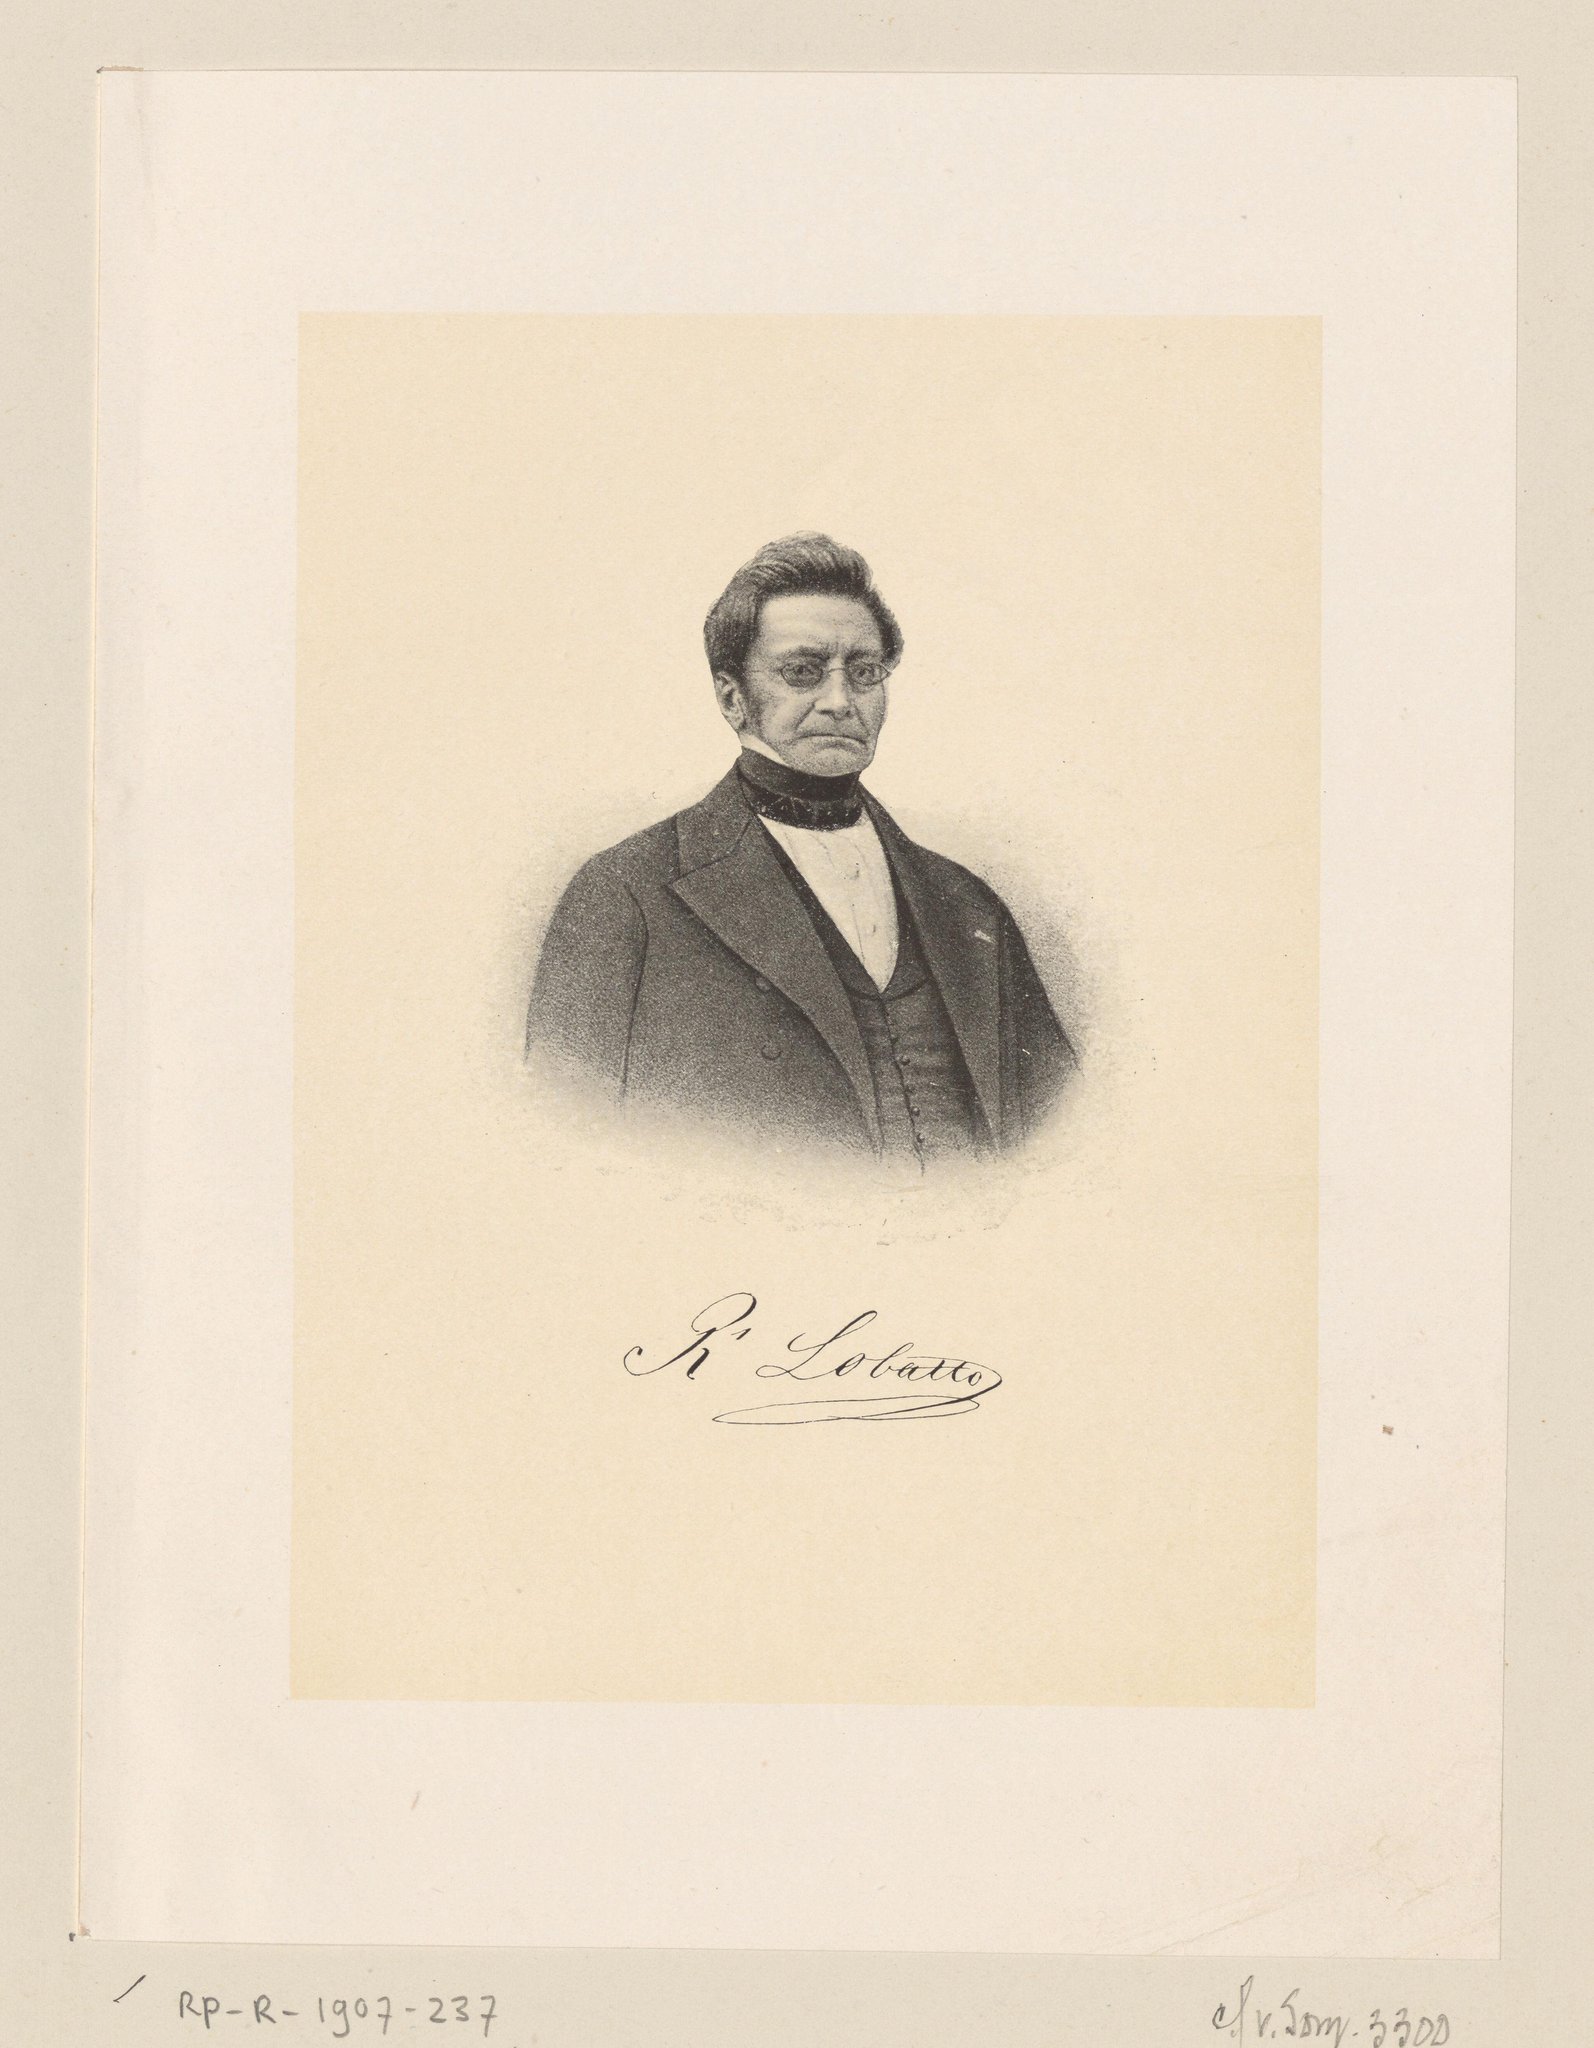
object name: reproduction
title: Portret van Rehuel Lobatto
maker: Anonymous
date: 1900-1907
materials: paper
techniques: autotype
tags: amsterdam, historical persons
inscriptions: collector's mark: Lugt 2228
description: Reproductie van een lithografie gedrukt door Koninklijke Nederlandse Steendrukkerij van C.W. Mieling.